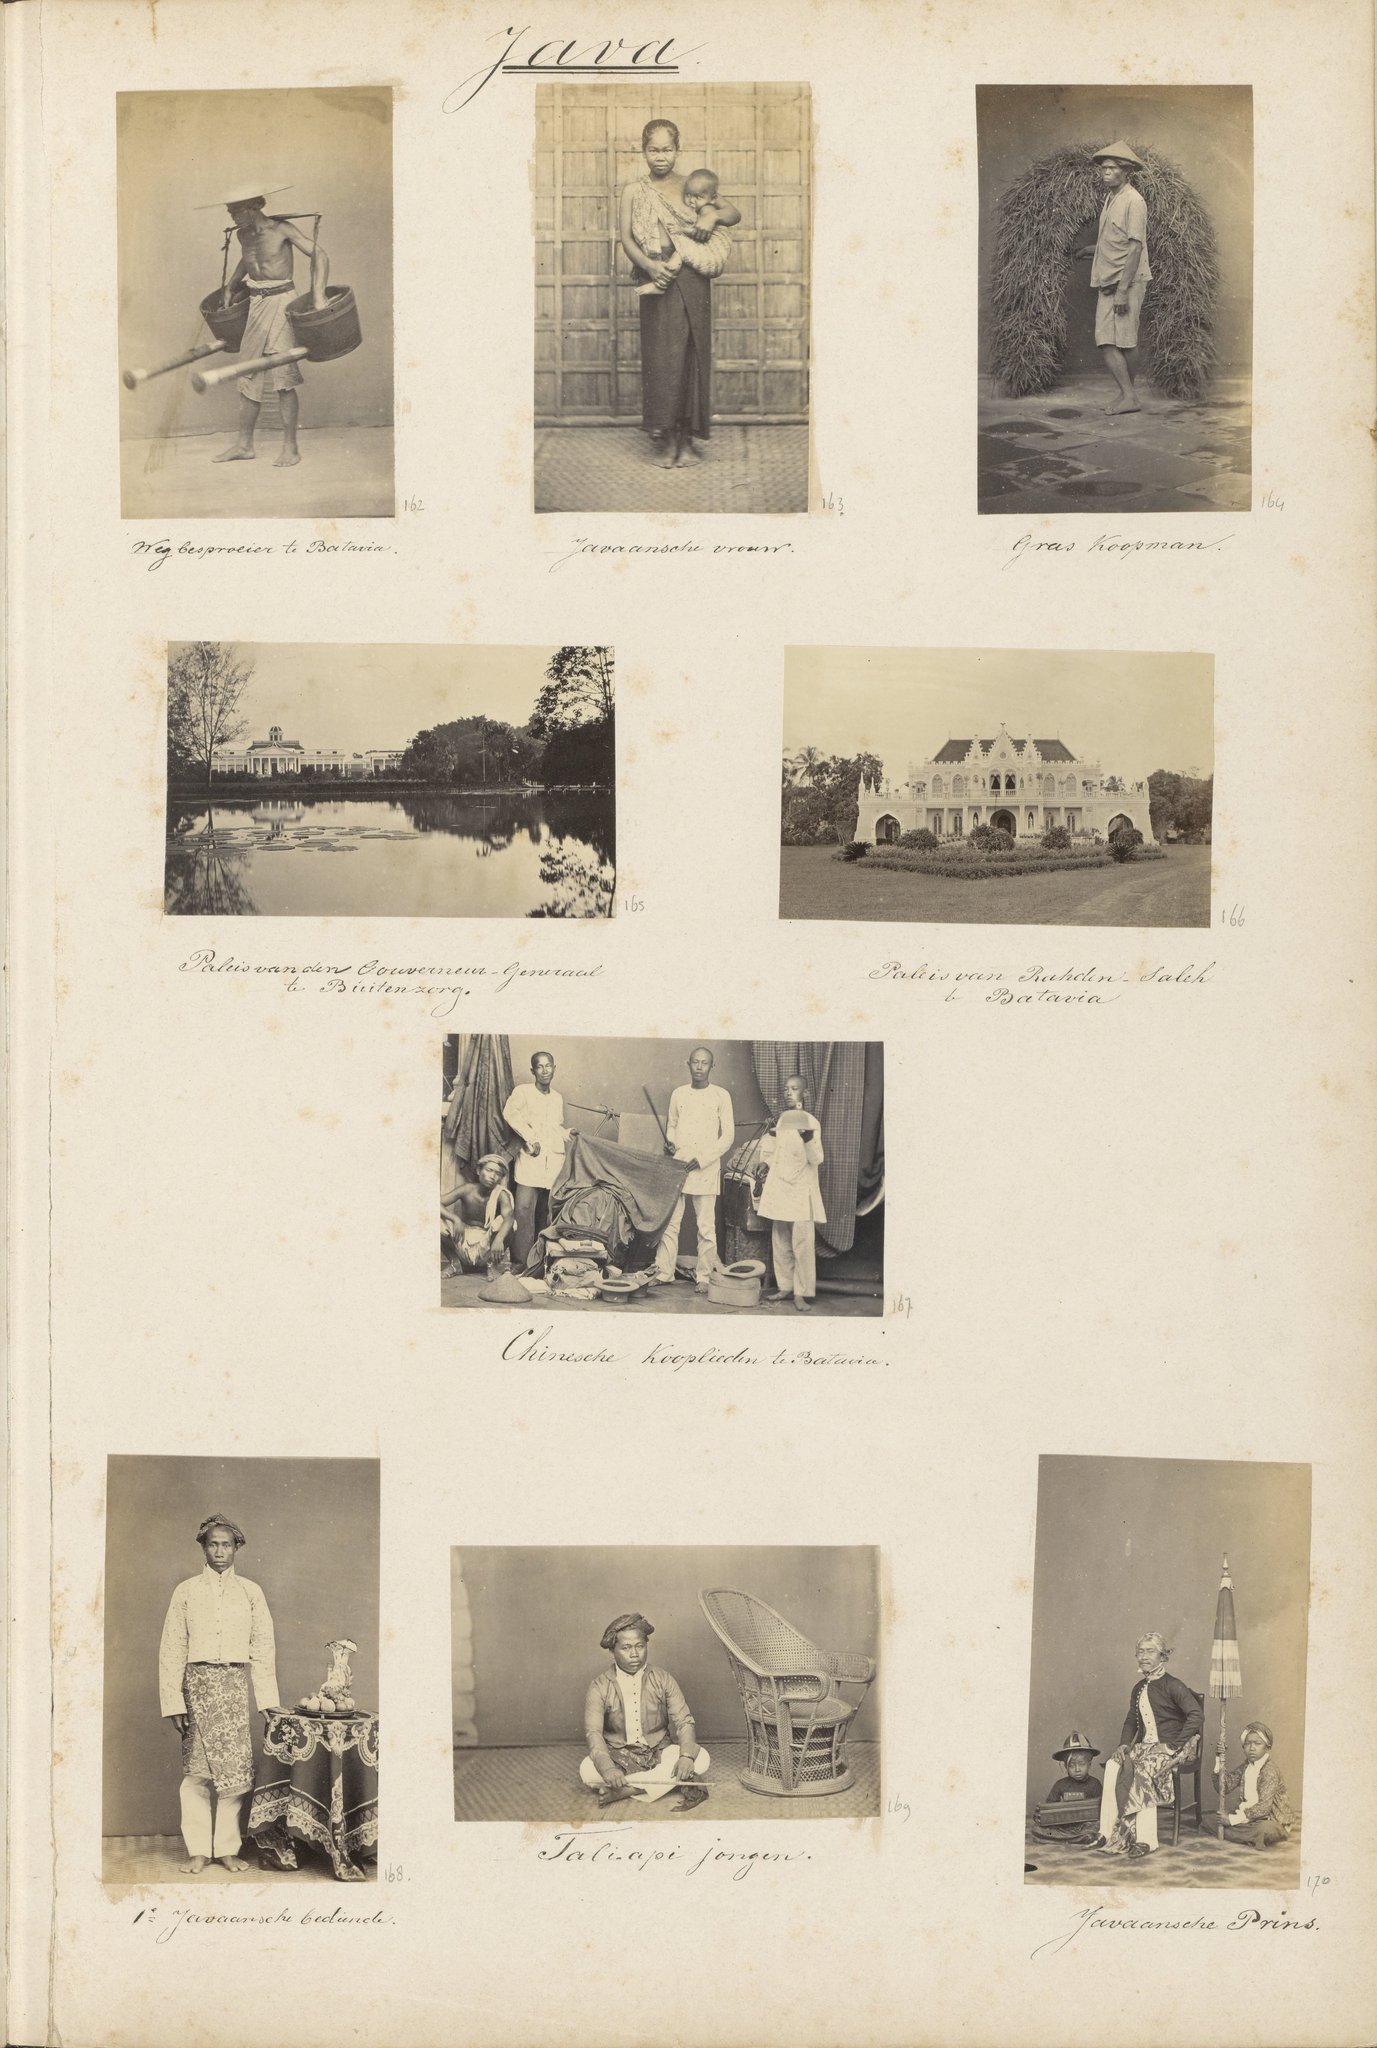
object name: album leaf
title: Portret van een Javaanse bediende bij een tafel met fruit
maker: Anonymous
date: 1870-1880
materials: paper, photographic support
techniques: albumen print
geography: java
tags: house personnel, servants, java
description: Onderdeel van Fotoalbum van Robert Daniel Crommelin (1841-1907).